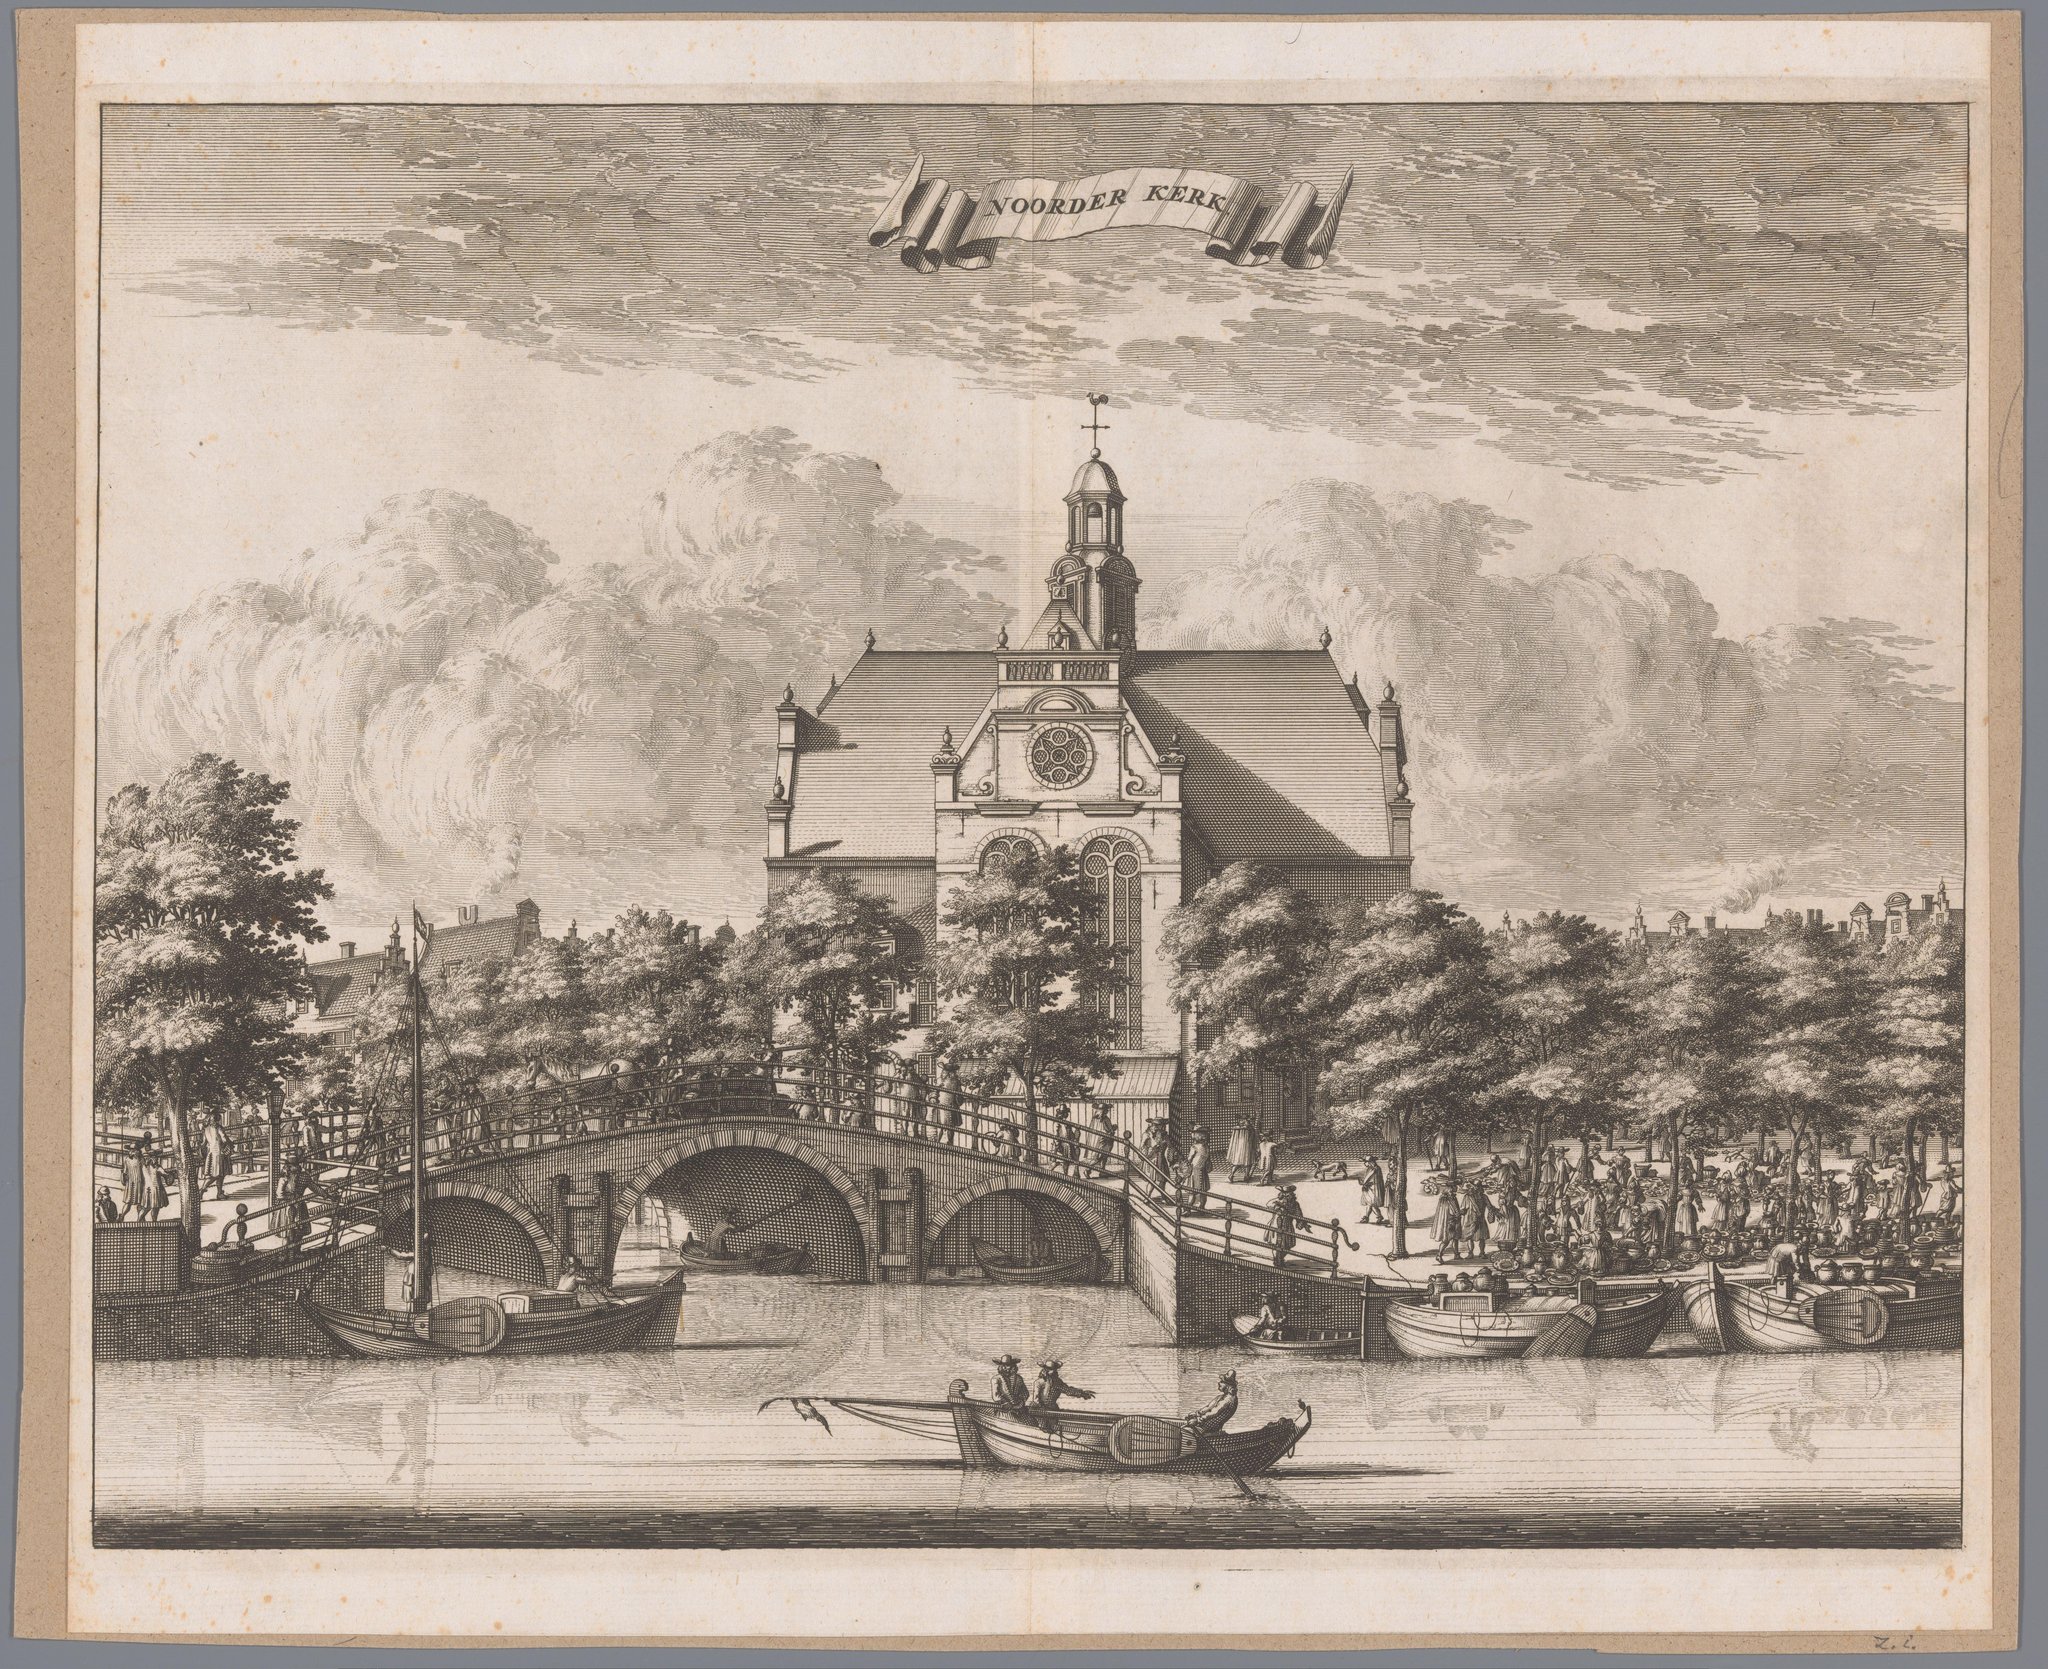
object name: book illustration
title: Gezicht op de Noorderkerk te Amsterdam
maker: Anonymous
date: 1693-1694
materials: paper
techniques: engraving, etching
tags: bridge in city across river, canal, etc. (+ city(-scape) with figures, staffage), church (exterior), market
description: Prent uit: Commelin, Caspar. Beschryvinge van Amsterdam, desselfs eerste oorspronk uyt den Huyse (…). Amsterdam: Abraham Wolfgang et al., 1693. Of uit: Commelin, Caspar. Beschryvinge van Amsterdam, zynde een naukeurige verhandelinge van desselfs eerste oorspronk uyt (…). Amsterdam: weduwe Aart Dircksz Oossaan, 1694. Latere staat van de prent werd gebruikt in: Commelin, Caspar. Beschryvinge van Amsterdam, zynde een naukeurige verhandelinge van desselfs eerste oorspronk uyt (…). Amsterdam: Andries van Damme et al., 1726. Zie voor deze staat: RP-P-2018-4000.